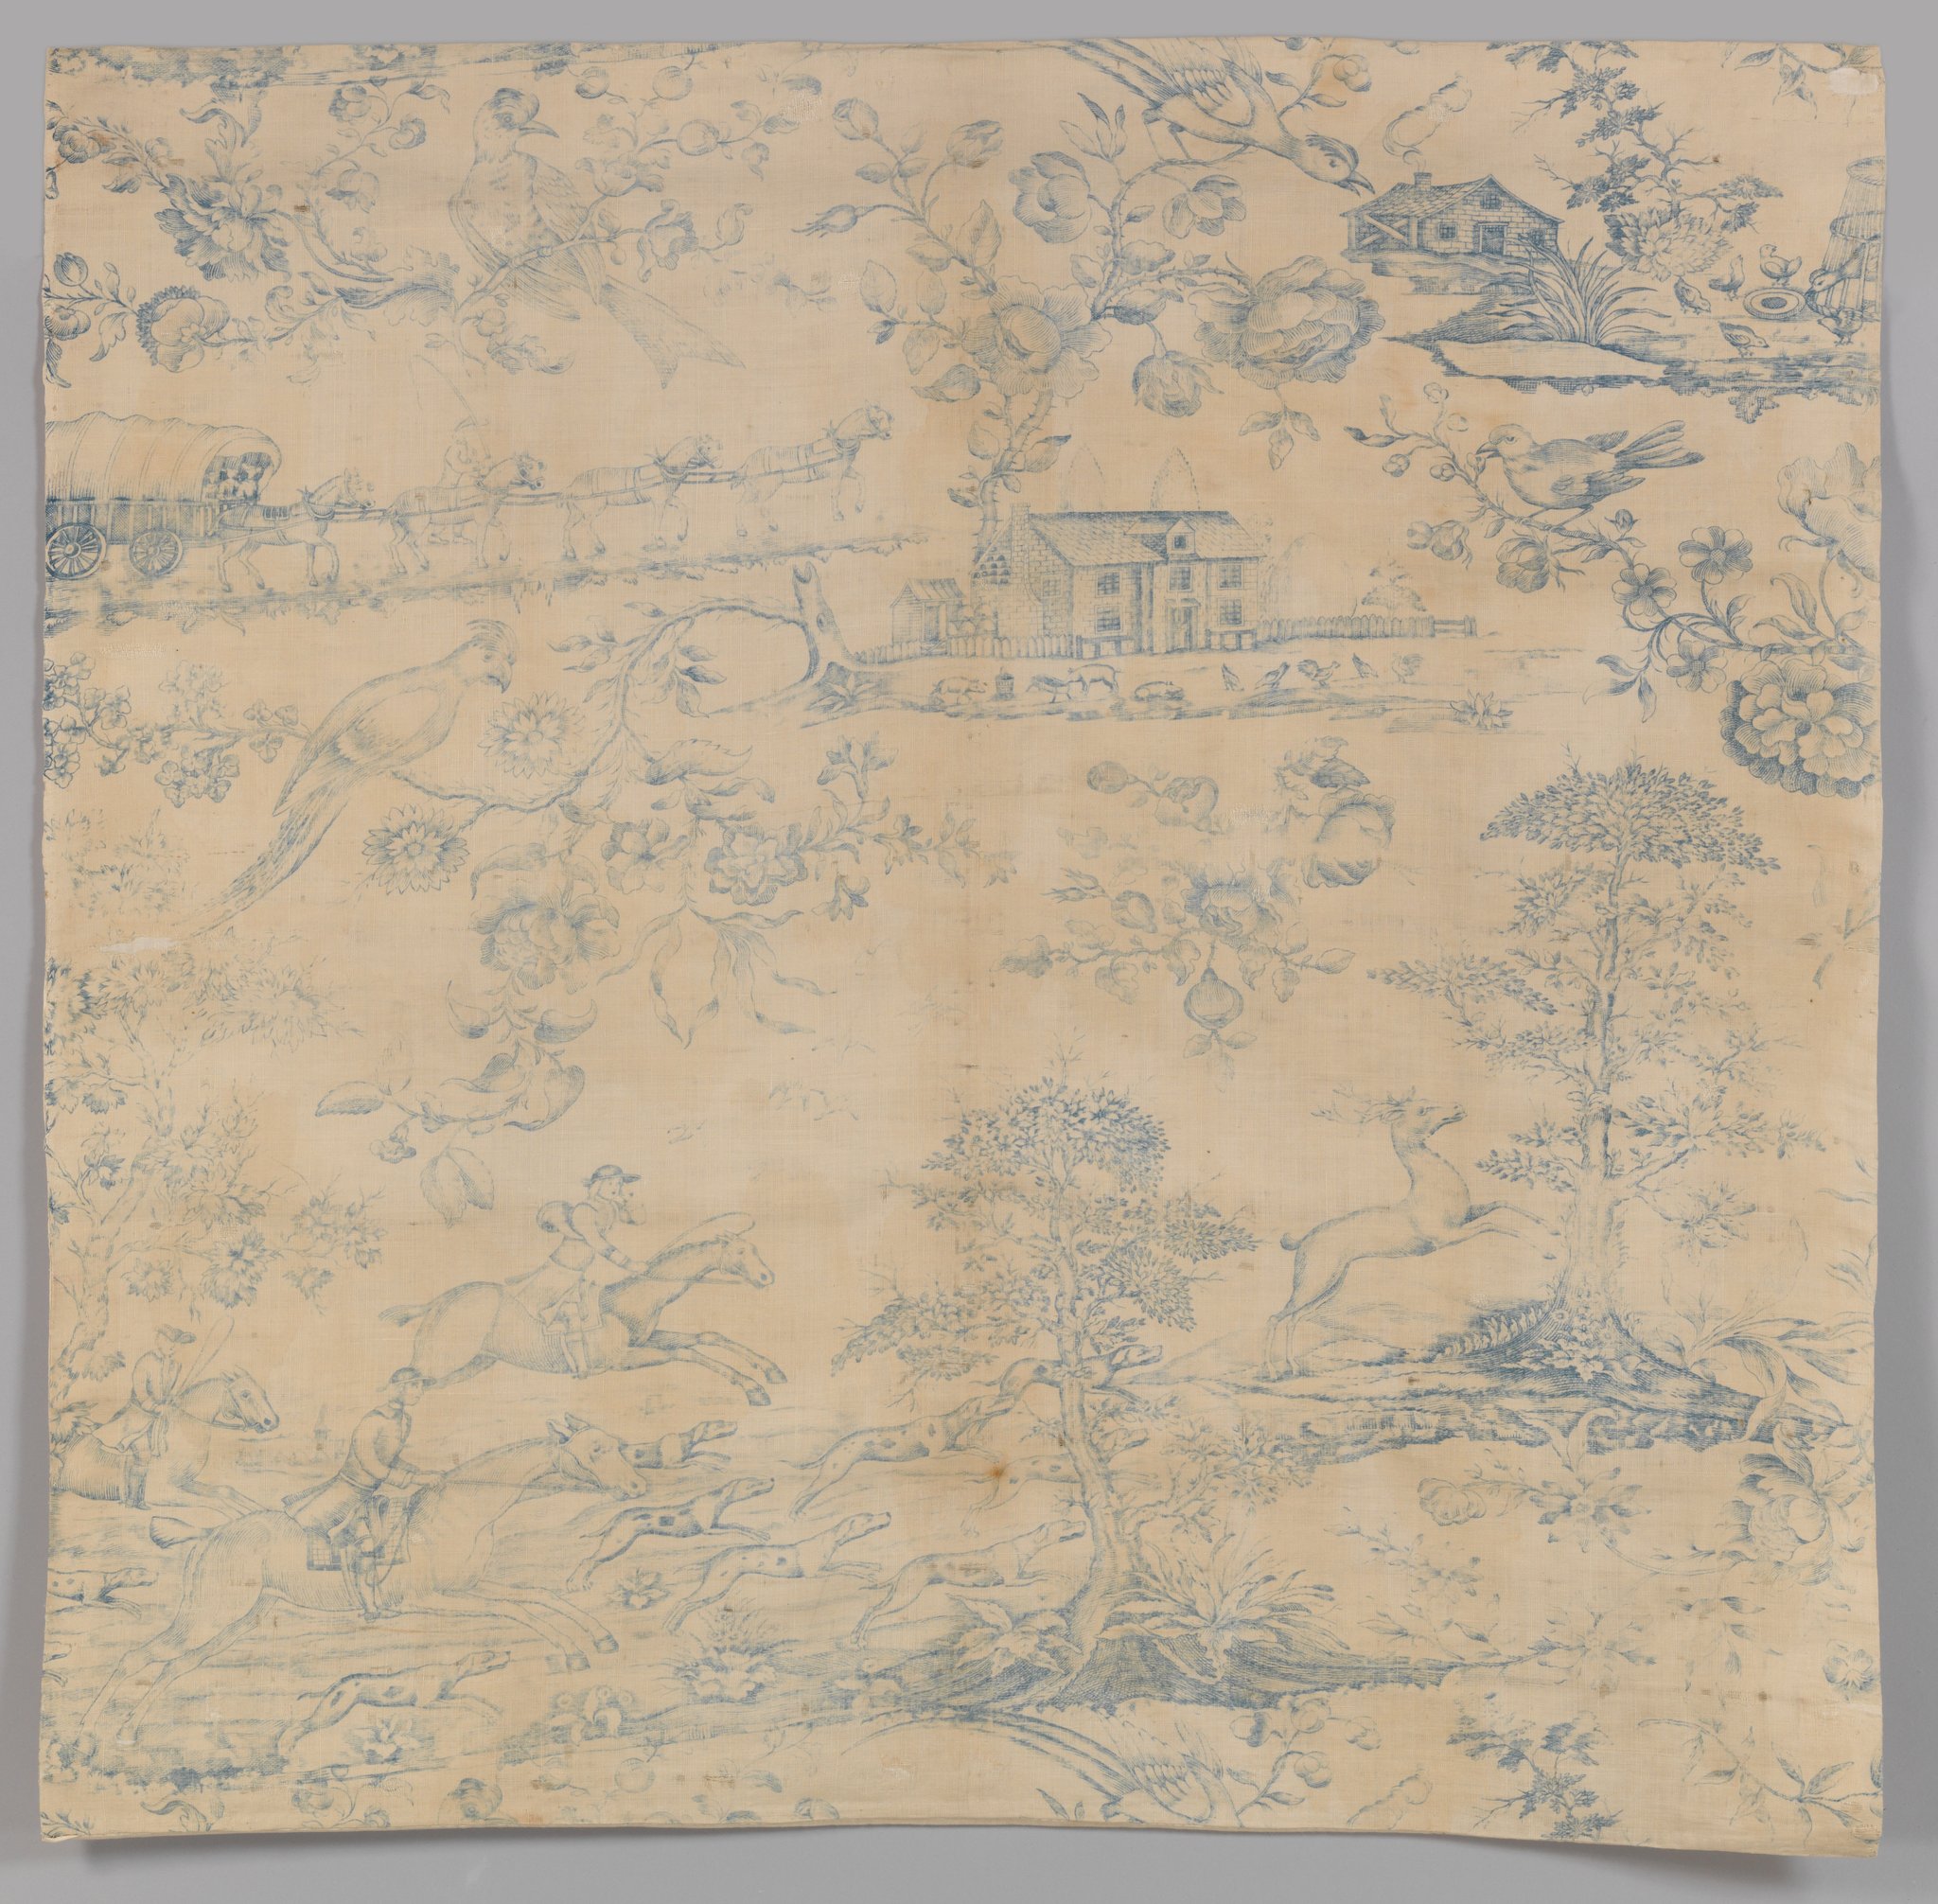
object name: piece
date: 1770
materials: cotton, linen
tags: birds,flowers,trees,carriages